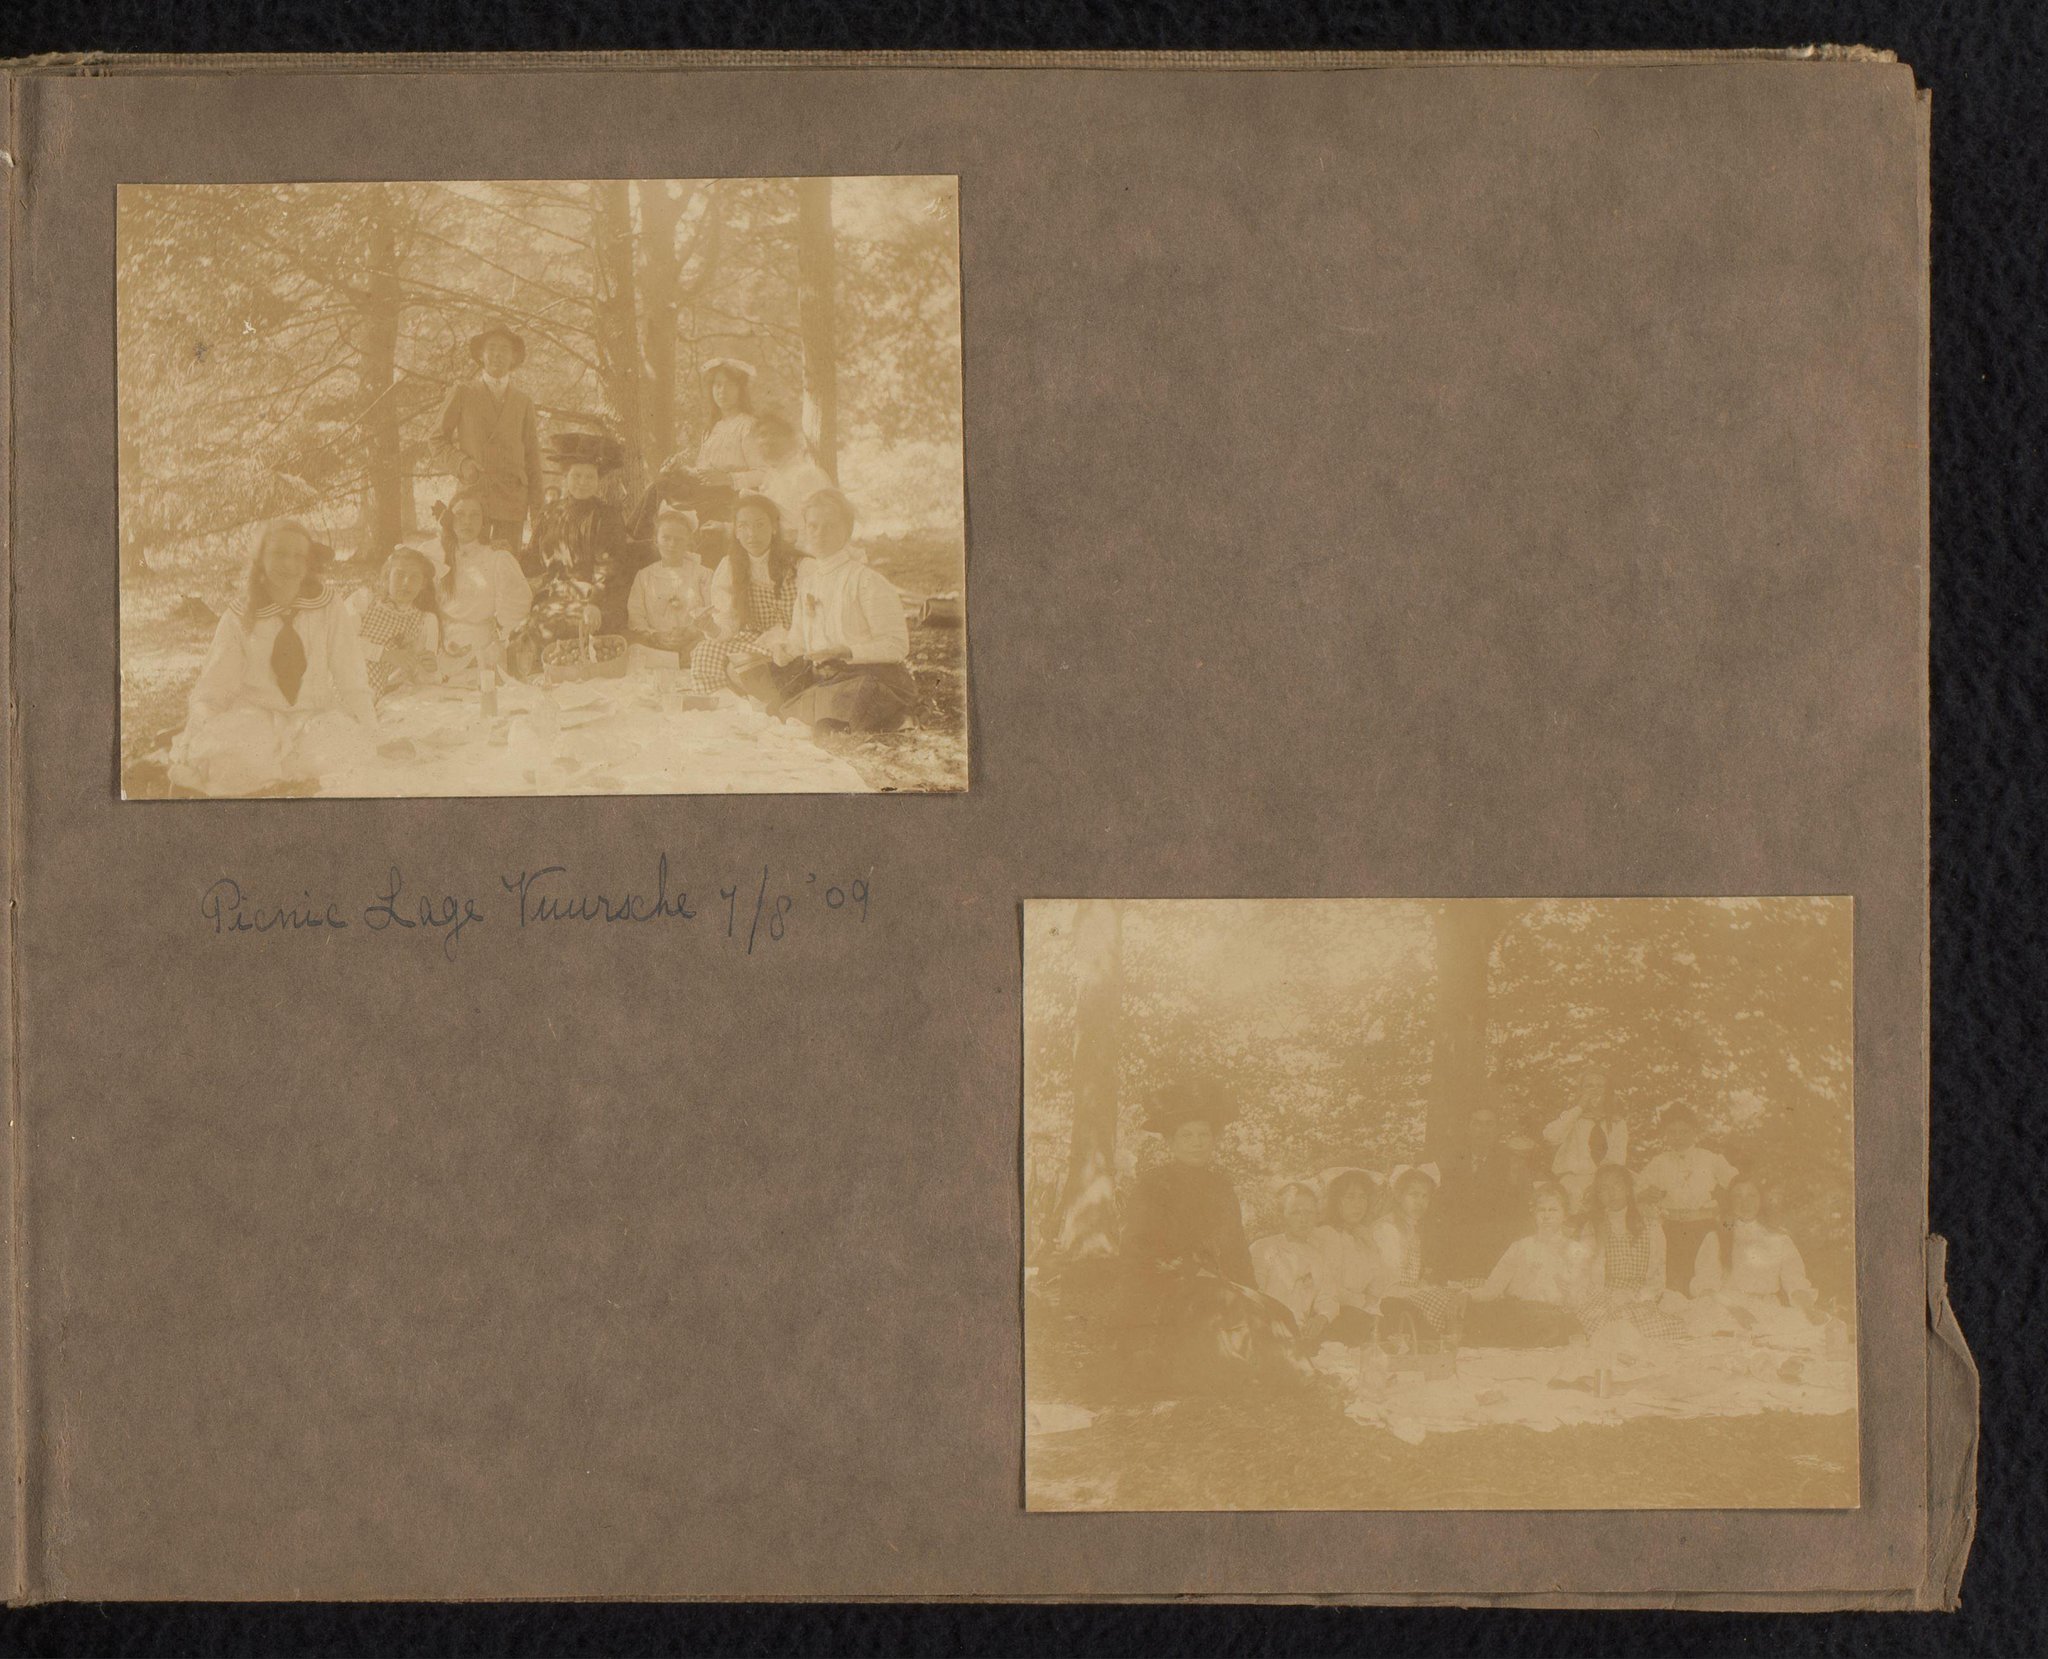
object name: photograph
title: Picnic Lage Vuursche 7/8 '09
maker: carolina frederika onnen (lien/loen)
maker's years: 1896-1983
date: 1909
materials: paper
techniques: gelatin silver print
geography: lage vuursche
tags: family group, especially parents with their child(ren), picnic, alfresco, 'déjeuner sur l'herbe', anonymous historical persons portrayed in a group, in a group-portrait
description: Deze foto's maken deel uit van een album.